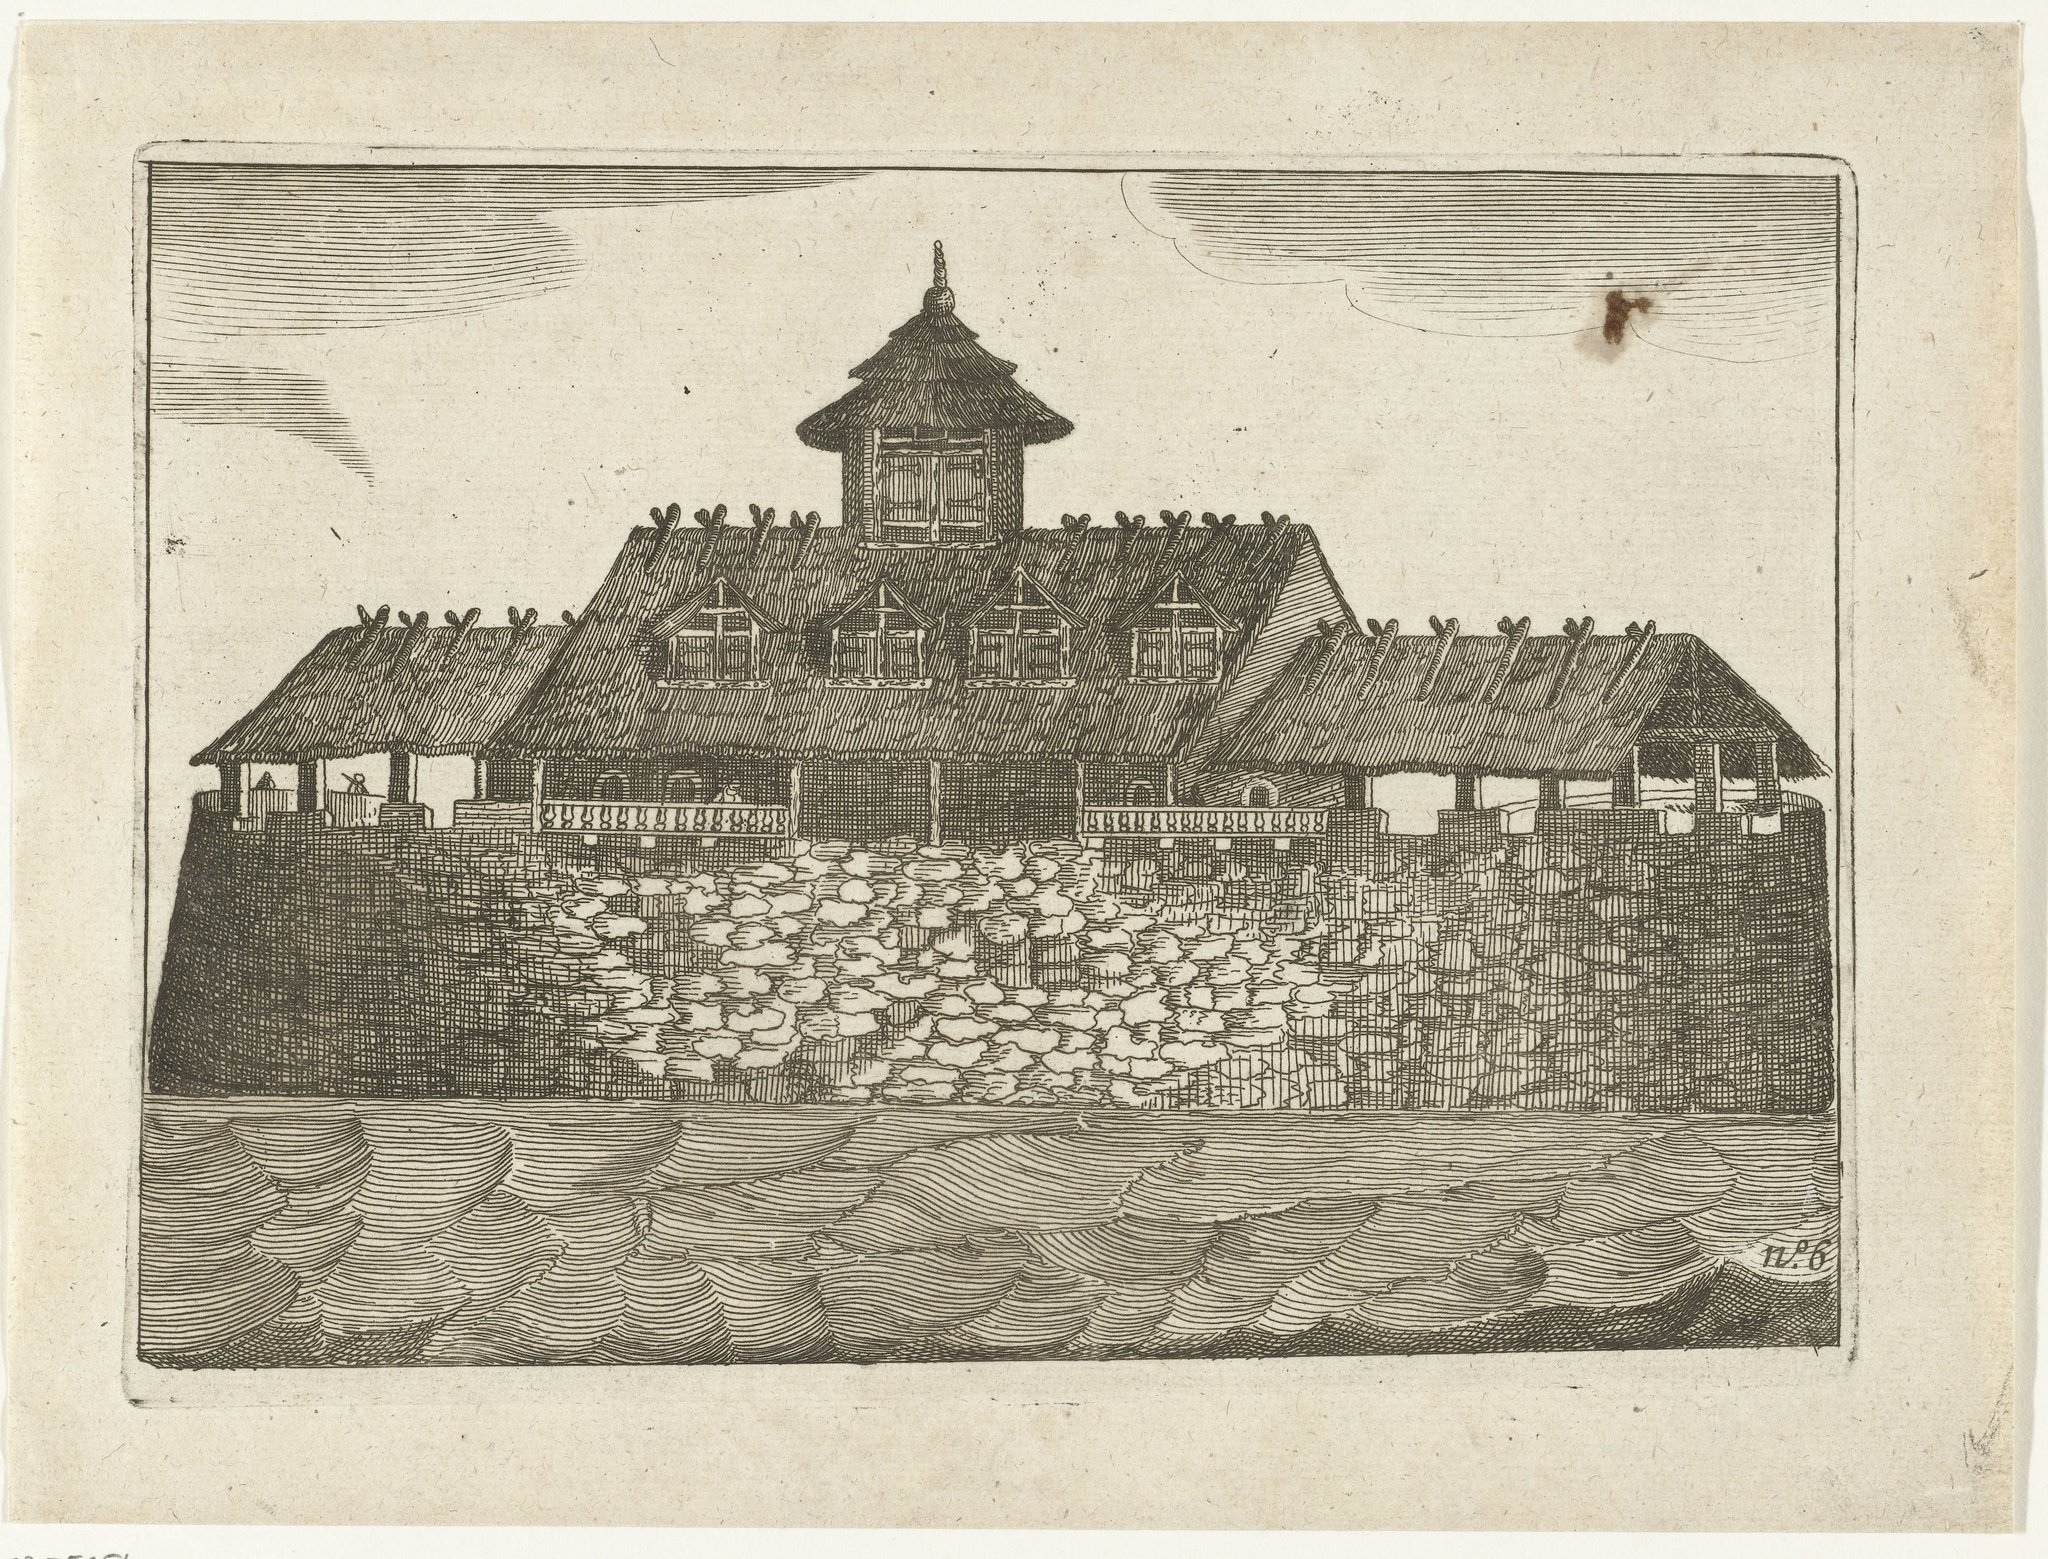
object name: print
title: Het Casteel Amboyna, soo 't hem van de Water-cant ende uyt de Shepen vertoont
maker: Anonymous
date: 1644-1646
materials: paper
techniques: etching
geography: northern netherlands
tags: landscapes in tropical and sub-tropical regions, exploration, expedition, voyage of discovery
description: Gebruikt als illustratie: Historisch Verhael Vande treffelijcke Reyse, gedaen naer de Oost-Indien ende China, met elf Schepen. Door den Manhaften Admirael Cornelis Matelief de Jonge. Inden Jaren 1605. 1606. 1607. ende 1608. Deze tekst opgenomen in : I. Commelin, Begin ende voortgangh, van de Vereenighde Nederlantsche Geoctroyeerde Oost-Indische Compagnie, J. Janssonius, Amsterdam 1646. Genummerd: No. 6.